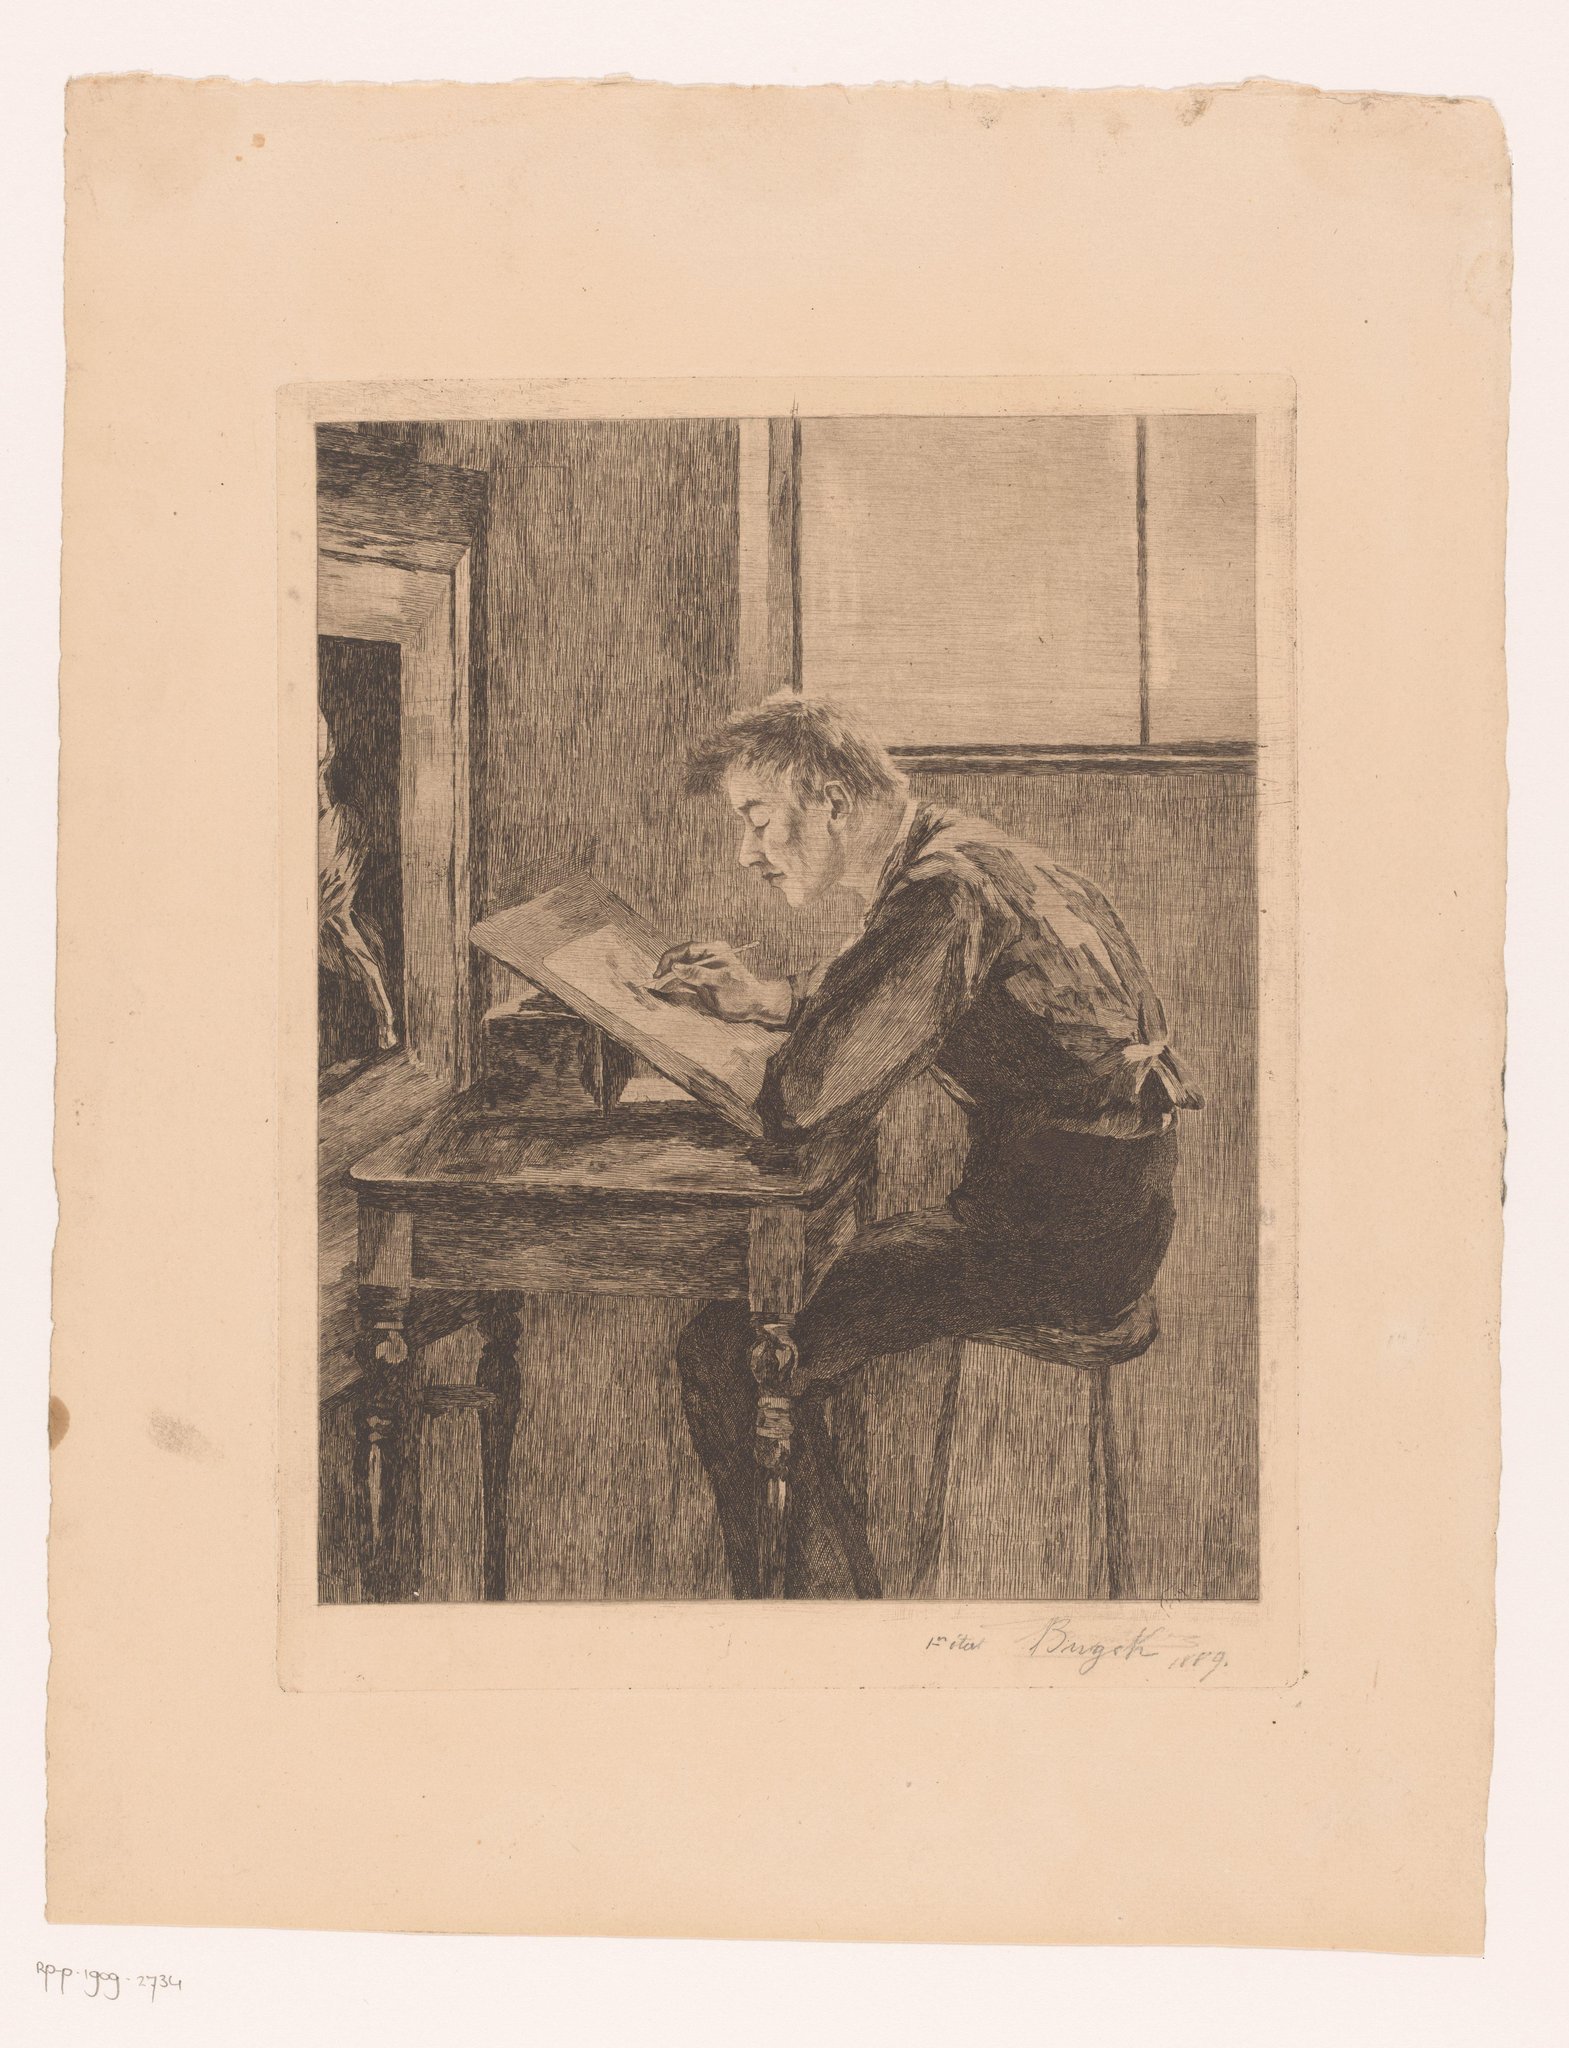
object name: print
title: Tekenaar over zijn werk gebogen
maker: florimond buyck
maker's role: print maker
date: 1889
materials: paper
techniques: etching, intaglio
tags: draughtsman at work, portrait, self-portrait of artist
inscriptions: collector's mark: Lugt 2228, annotation: ‘1er état’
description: Sterfdatum prentmaker onbekend. Derhalve is voor bepaling van de rechten van dit object de verwervingsdatum aangehouden.